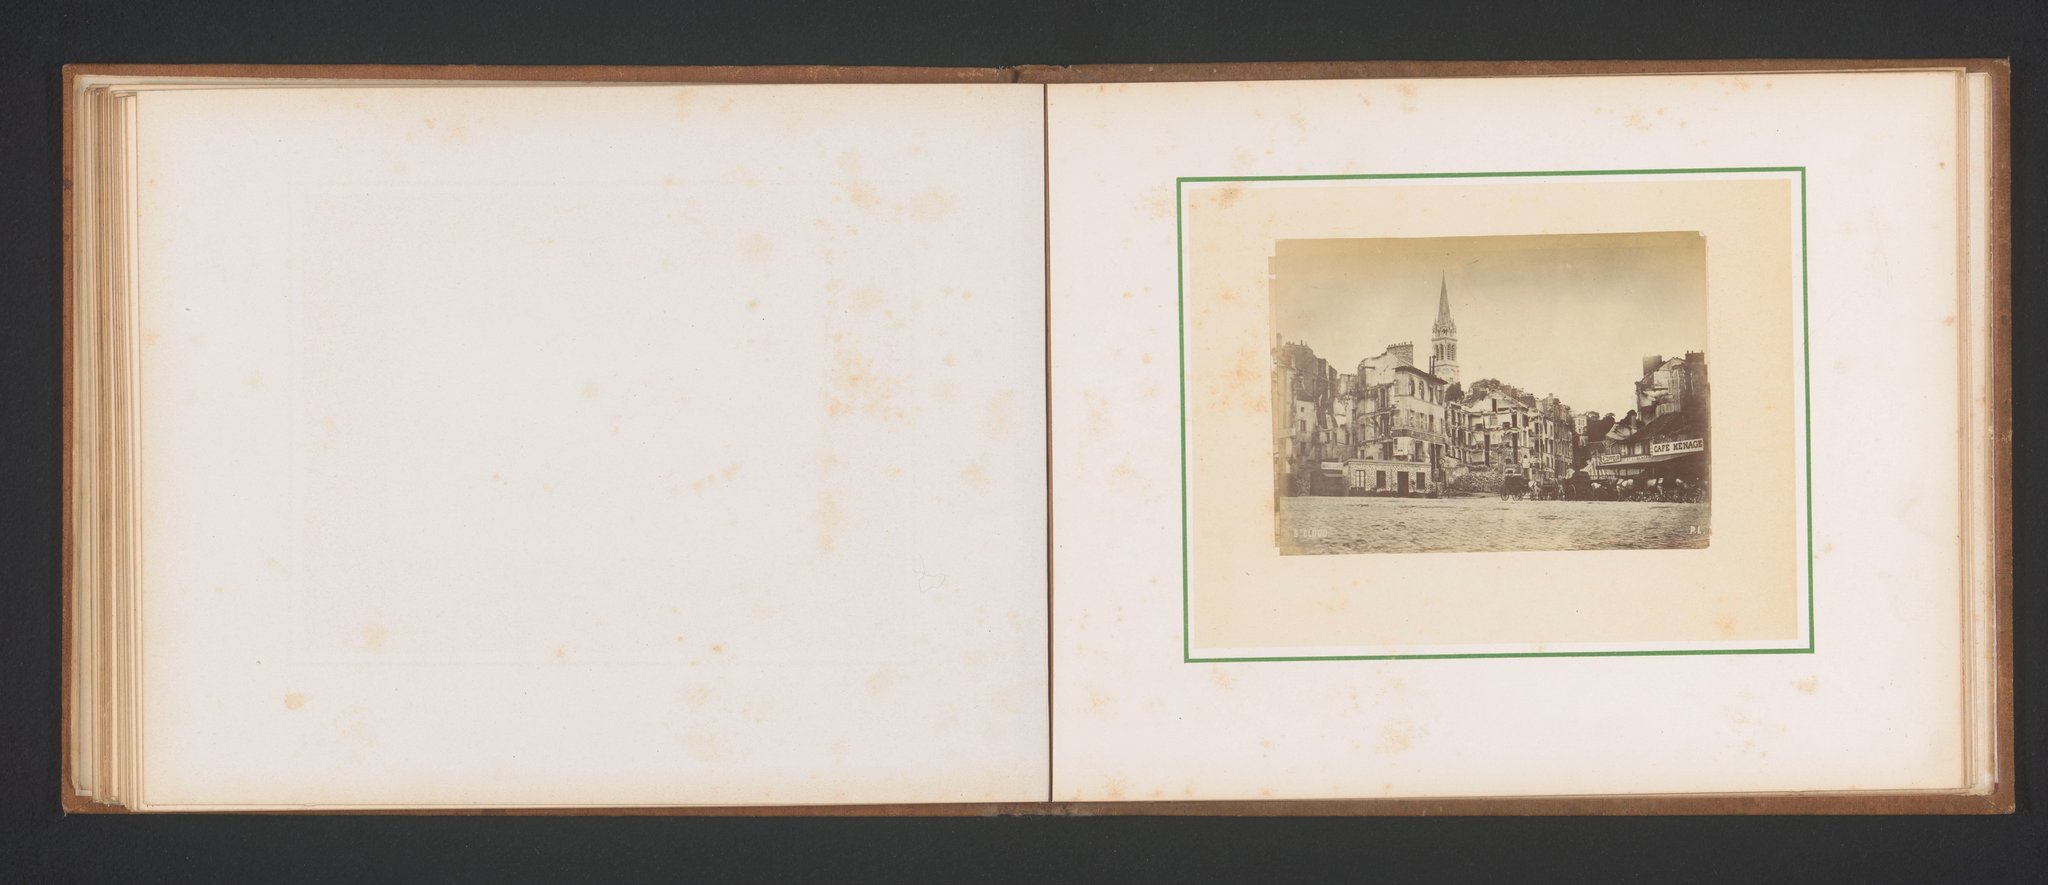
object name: photograph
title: Gezicht op het Place d'Armes in Saint-Cloud vlakbij Parijs na de brand door de Commune van Parijs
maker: p. loubère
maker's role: fotograaf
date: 1871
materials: photographic support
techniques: albumen print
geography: paris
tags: square, place, circus, etc., ruin of a building ~ architecture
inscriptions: monogram: ‘P.L.’